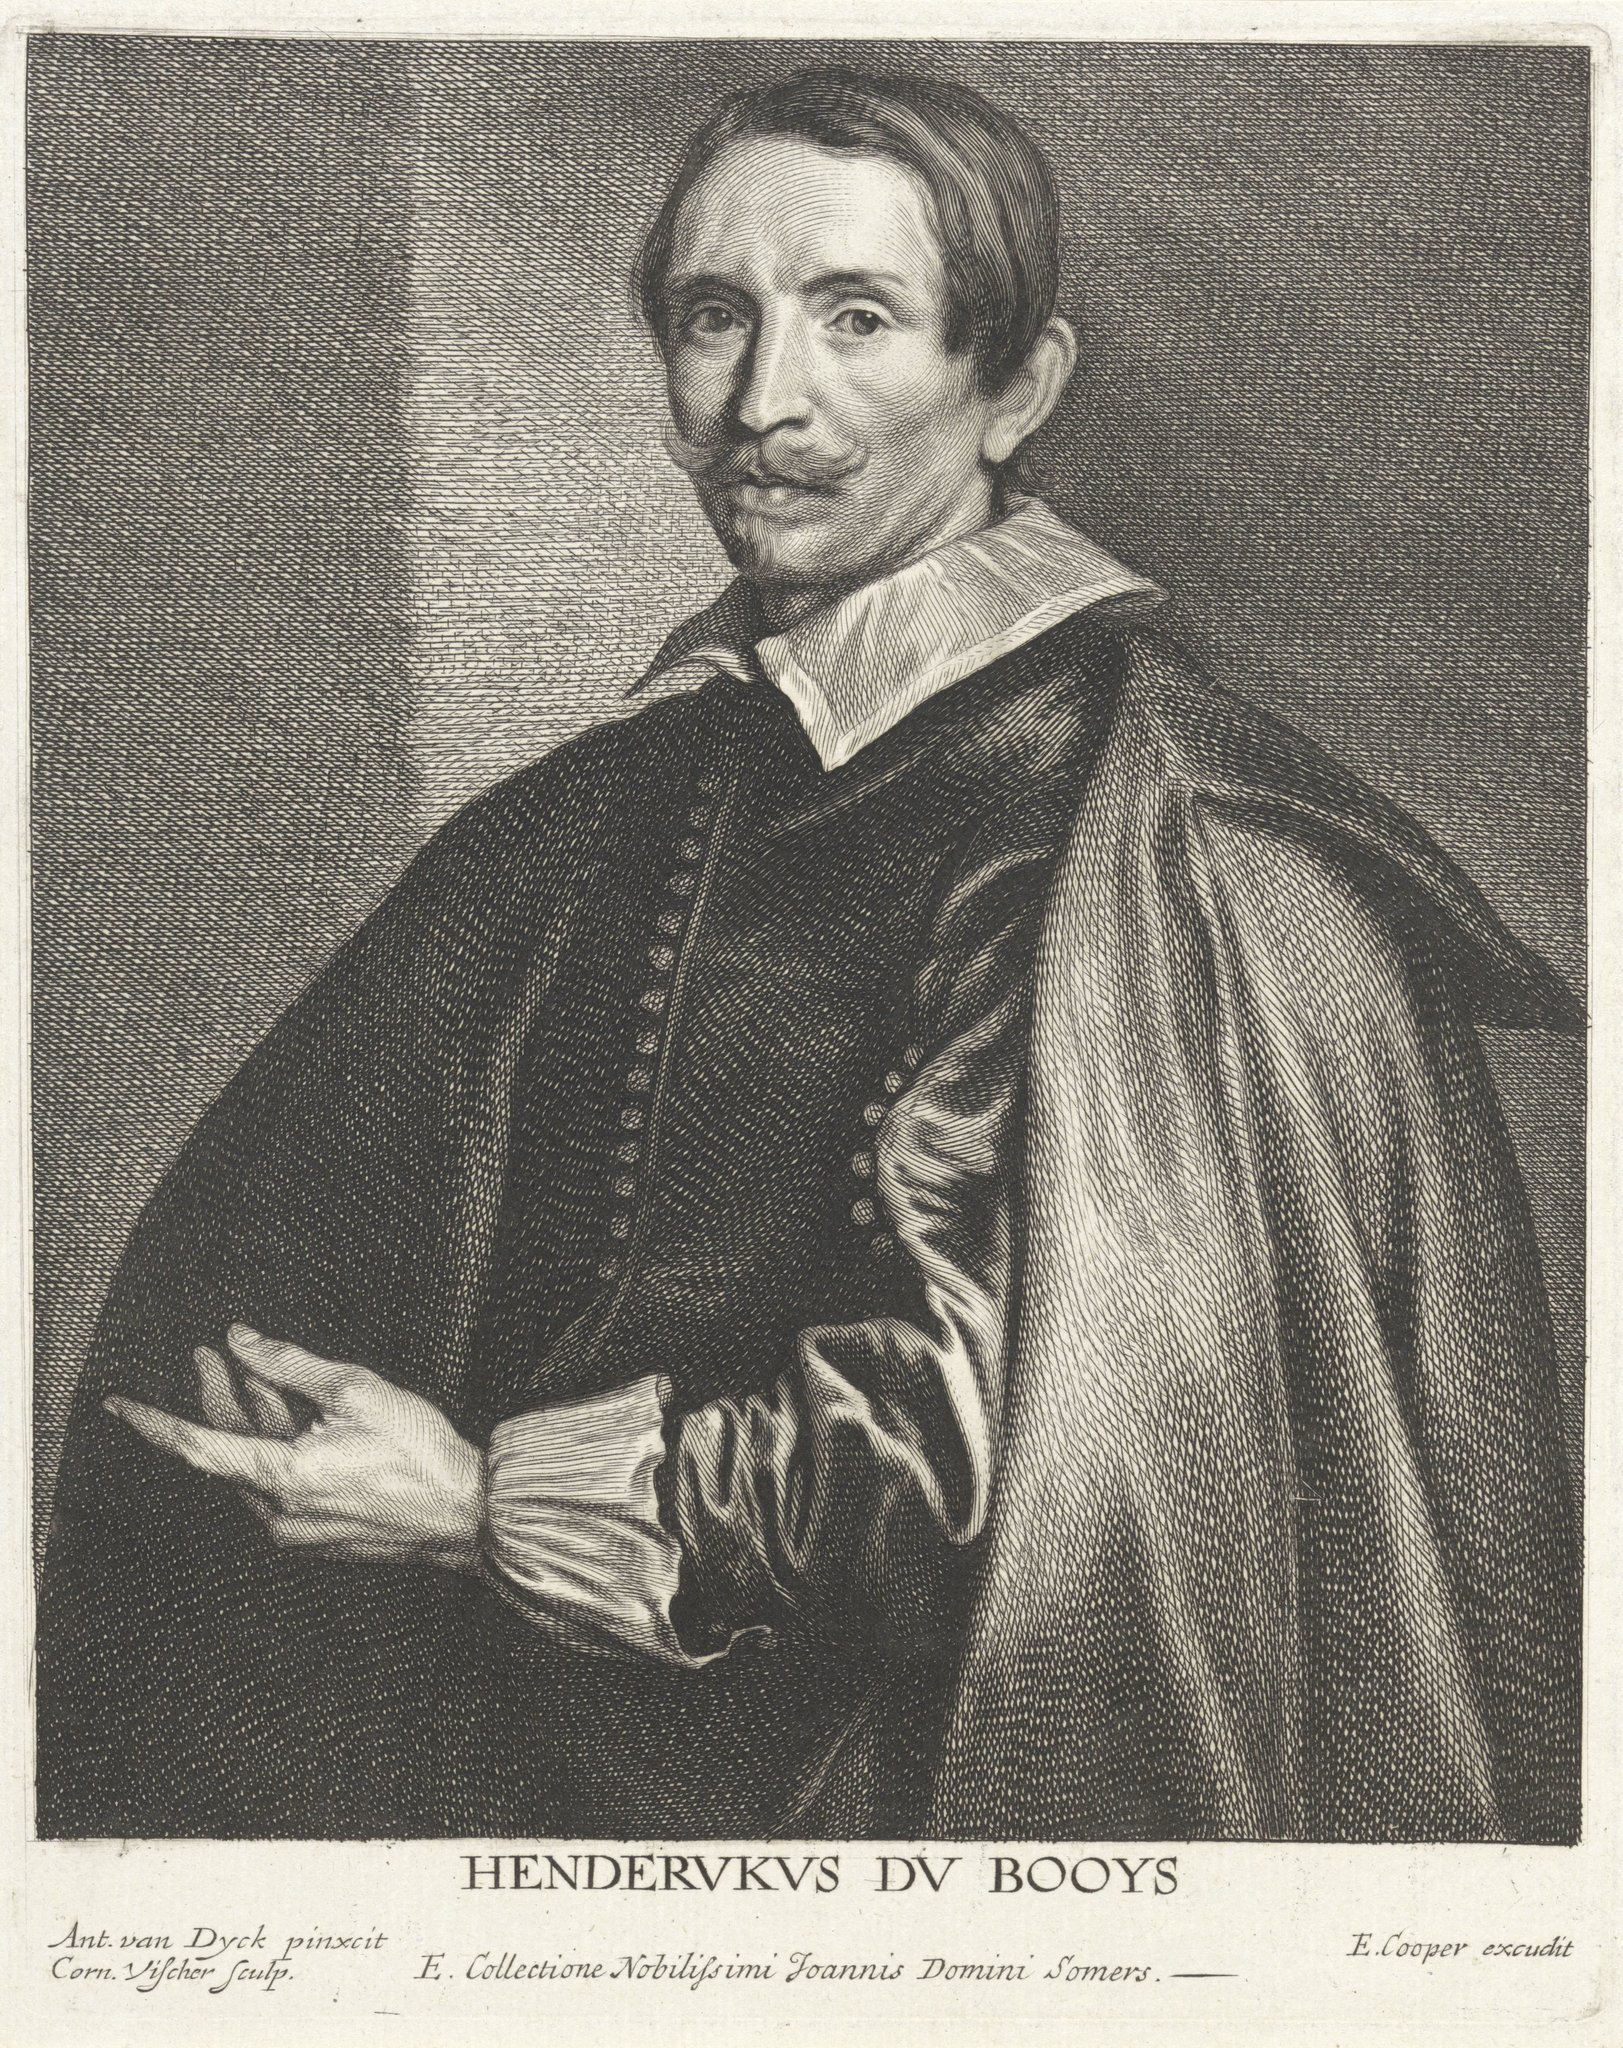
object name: print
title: Portret van de schilder Hendrick Dubois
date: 1682-1725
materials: paper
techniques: engraving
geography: london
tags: antwerp, painter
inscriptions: collector's mark: Lugt 240